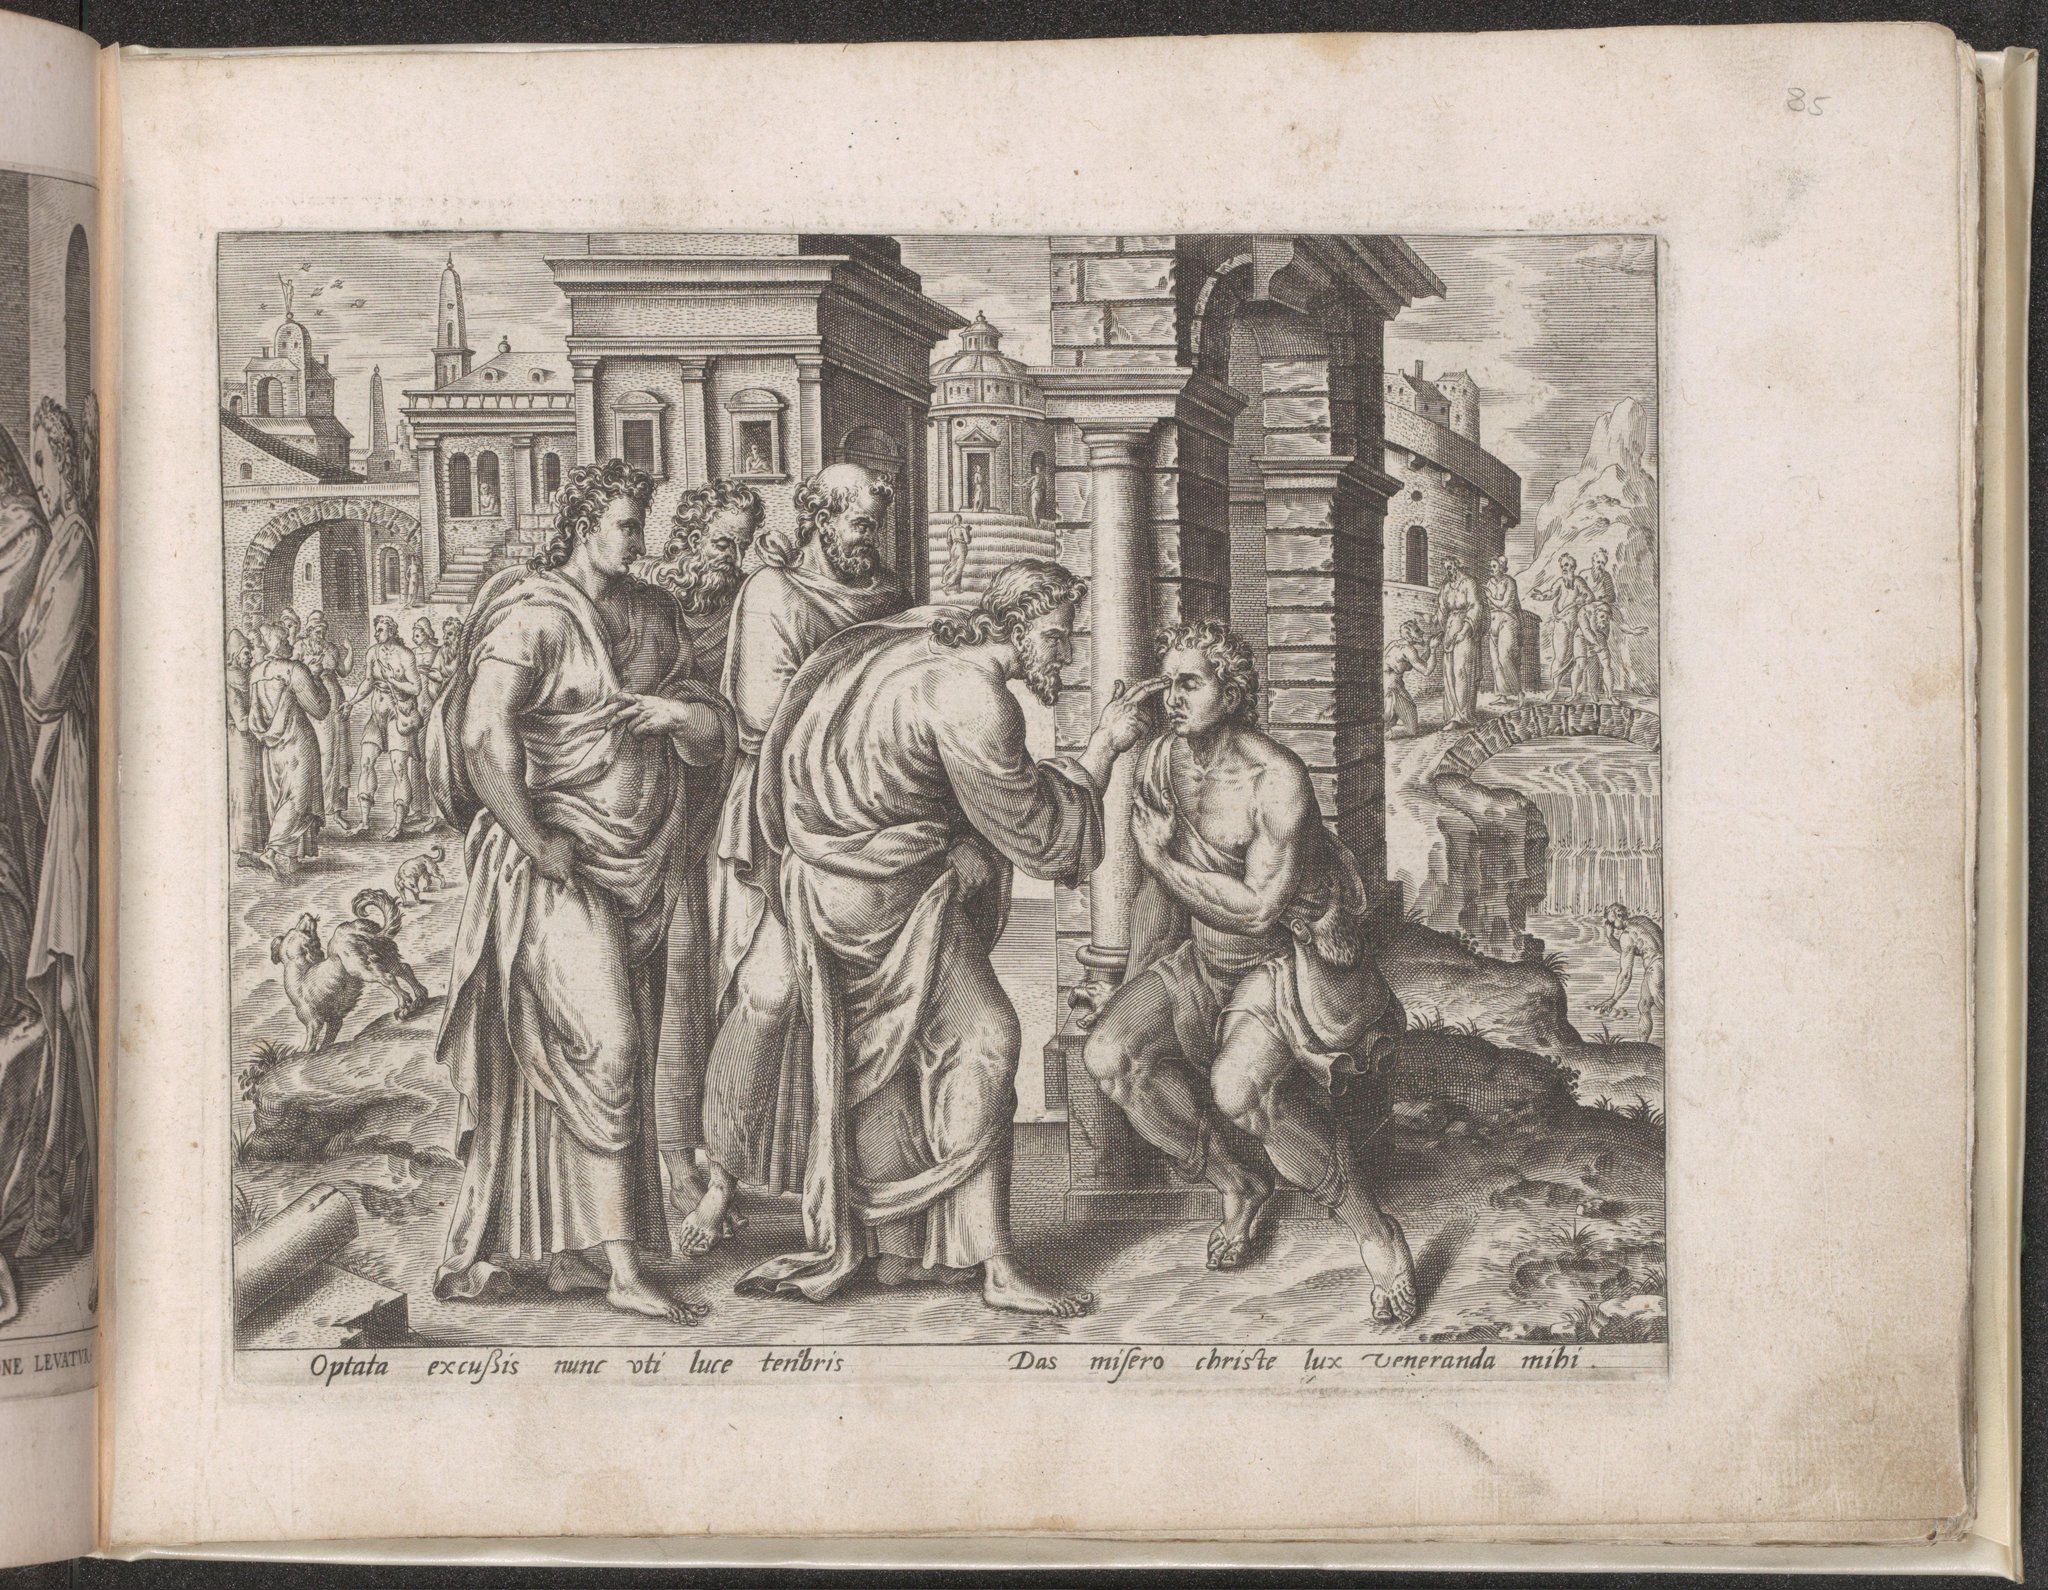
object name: album leaf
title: Christus geneest een blinde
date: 1572-1576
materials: paper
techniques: engraving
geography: antwerp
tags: the man born blind washes his eyes in the pool of siloam, and throws away his stick, healing of a man born blind: christ touches his eyes with an 'ointment' of dust and spittle (john 9)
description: Christus smeert modder en speeksel in de ogen van een blindgeboren man. Enkele van Christus' discipelen staan achter hem en kijken toe. Rechts is te zien hoe de blinde zich wast in een rivier (Siloam). Links worden de genezen man en zijn ouders door de farizeeën ondervraagd. Geheel rechts in de achtergrond knielt de genezen man voor Christus neer, nadat hij door de farizeeën is weggejaagd. Onder de voorstelling een verwijzing in het Latijn naar de Bijbeltekst in Joh. 9. Deze prent maakt deel uit van een album.